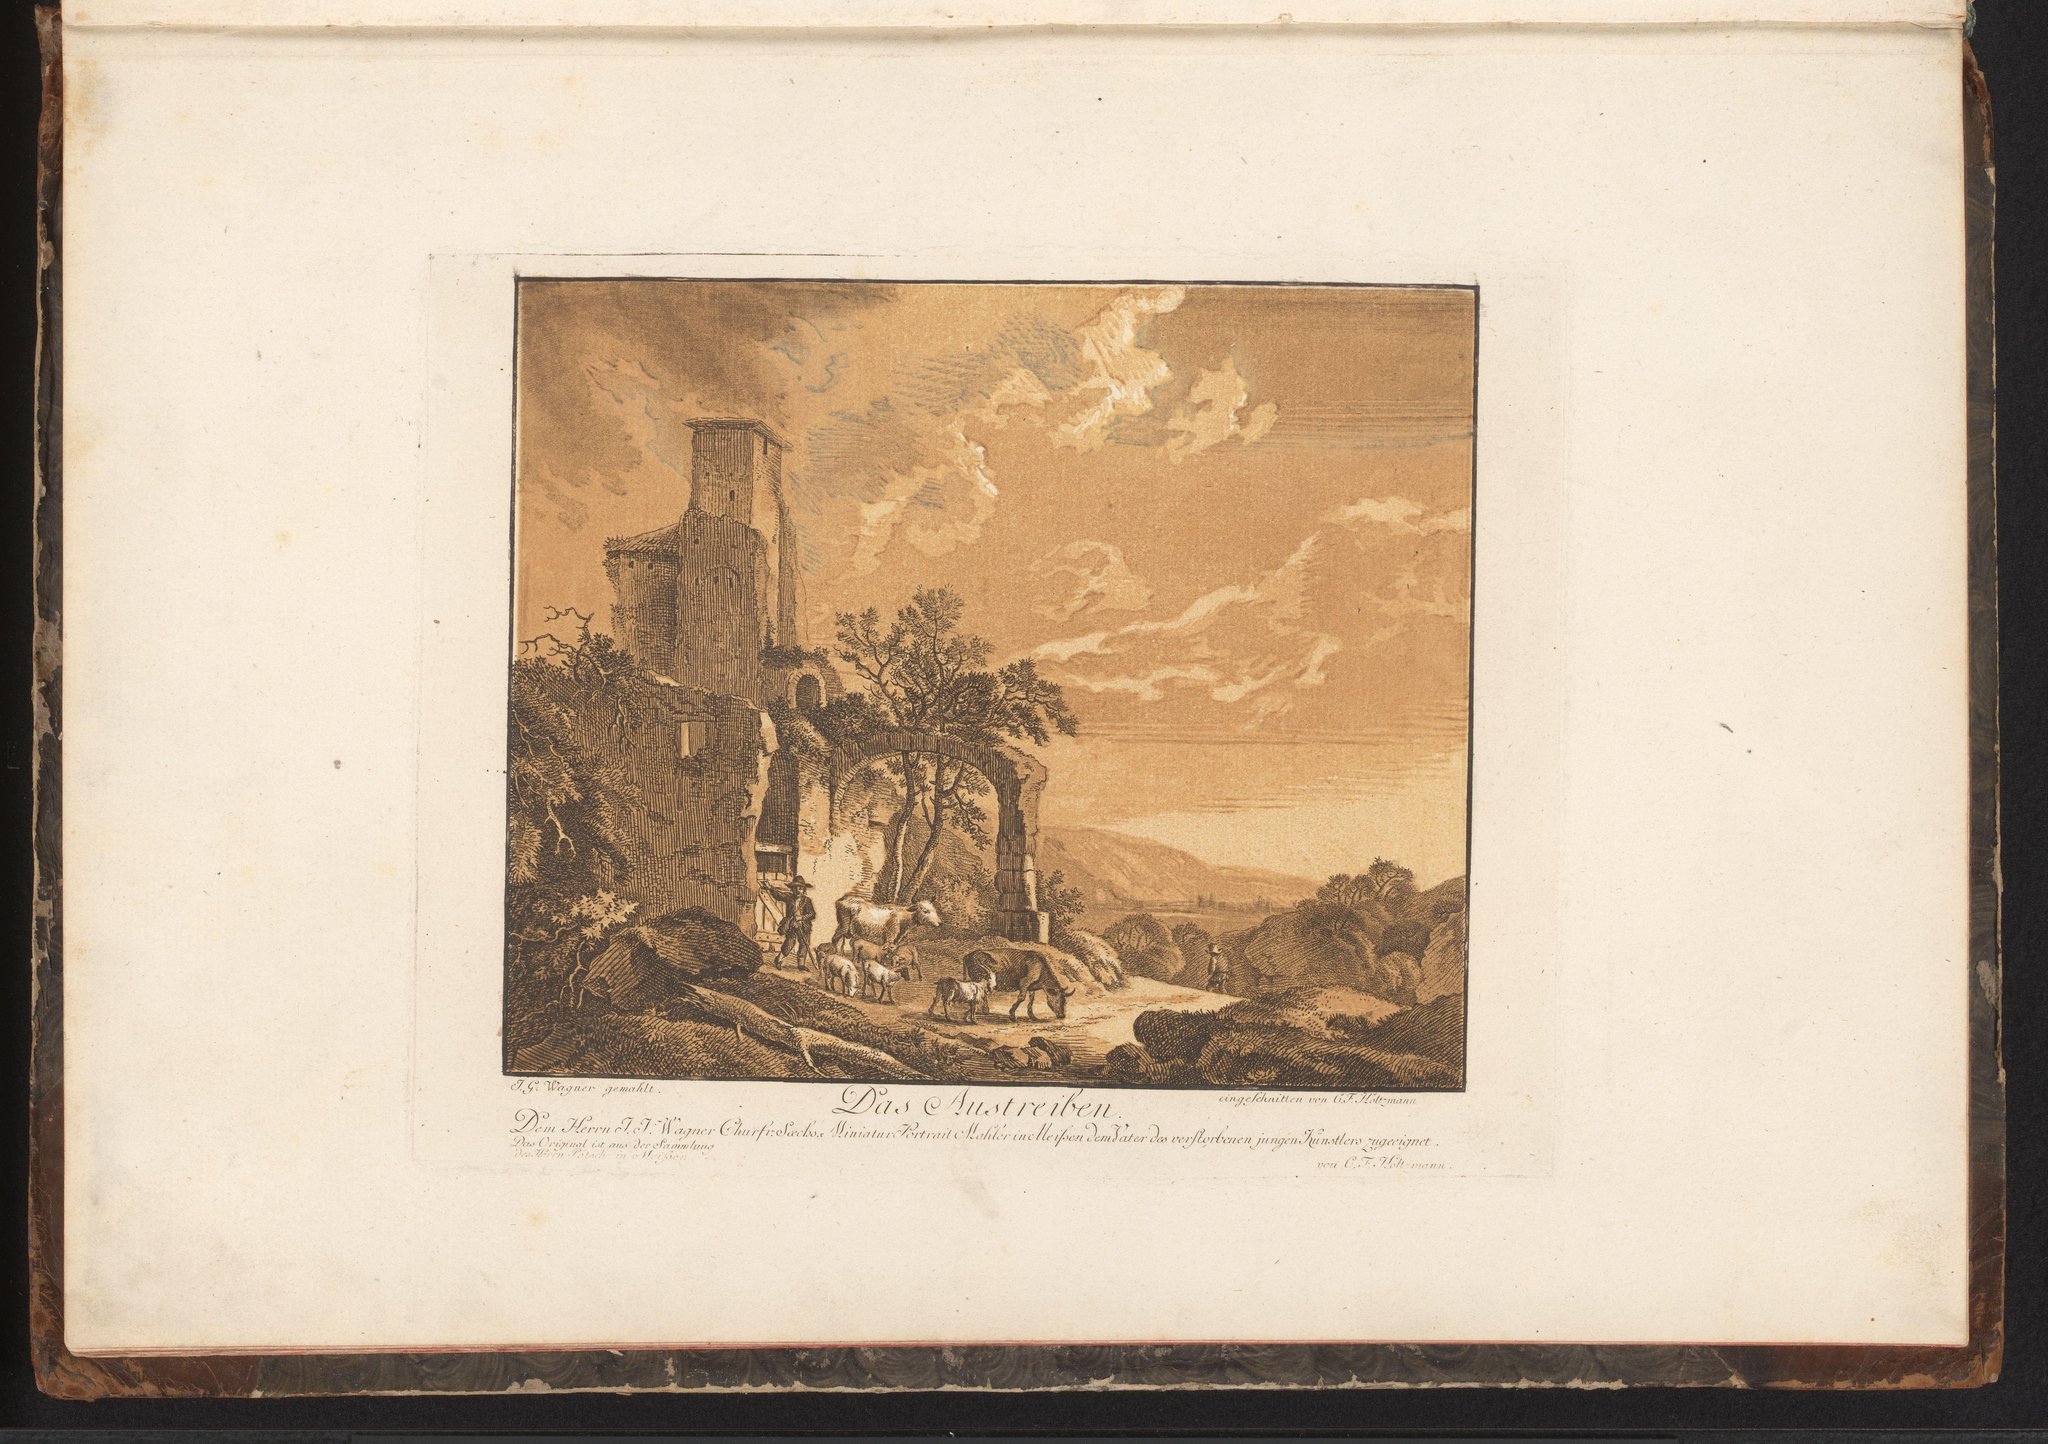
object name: print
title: Das Austreiben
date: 1750-1811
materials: paper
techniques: etching, intaglio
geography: dresden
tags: herding, herdsman, herdswoman, shepherd, shepherdess, cowherd, etc., landscape with ruins, cattle driving, cattle driver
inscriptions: collector's mark: Lugt 2228, collector's mark: Lugt 2760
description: Tekst in het Duits in de ondermarge. Prent maakt deel uit van een album.